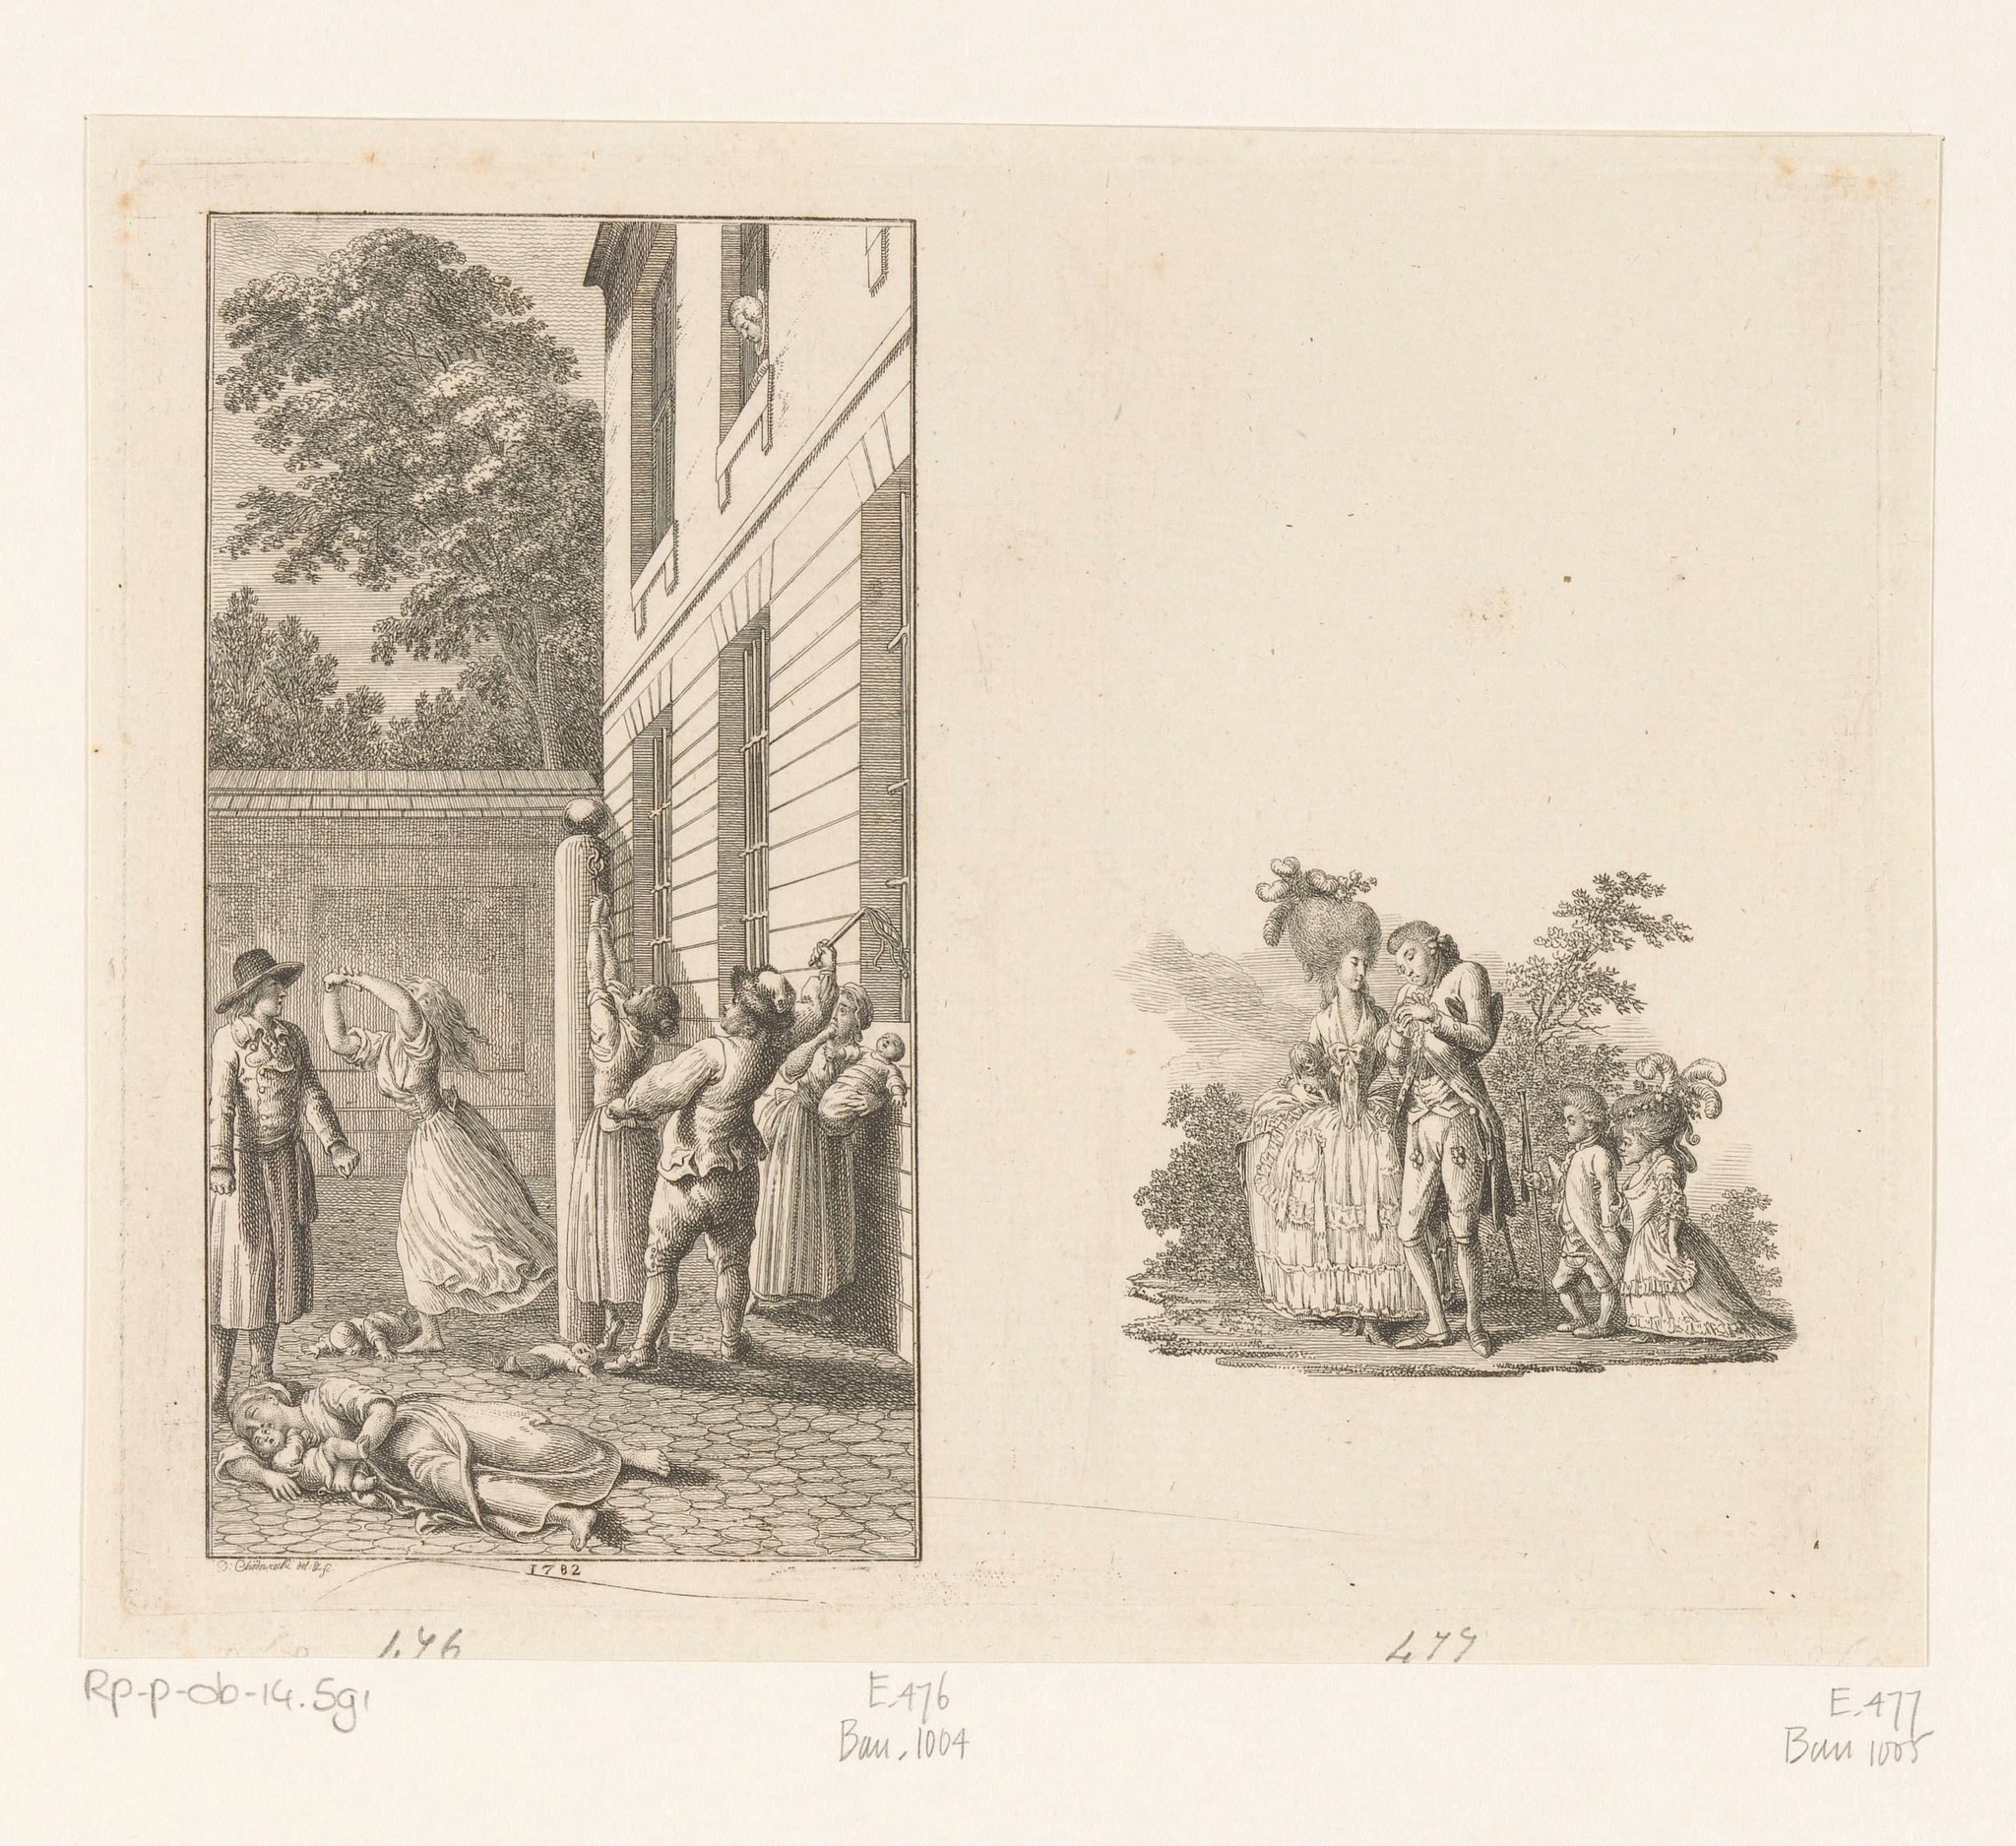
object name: print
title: Twee voorstellingen uit Salzmann's Carl von Carlsberg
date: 1782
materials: paper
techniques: etching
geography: berlin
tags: city-view, and landscape with man-made constructions, illegitimate child, bastard, literature, little people, flogging, scourging (in public), unmarried mother, arm in arm (lovers), dog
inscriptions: collector's mark: Lugt 2228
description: Prent gebruikt voor: Salzmann, Christian Gotthilf. Carl von Carlsberg oder über das menschliche Elend. 6 dln. Leipzig: Siegfried Lebrecht Crusius, 1783-1785, dl. 1.